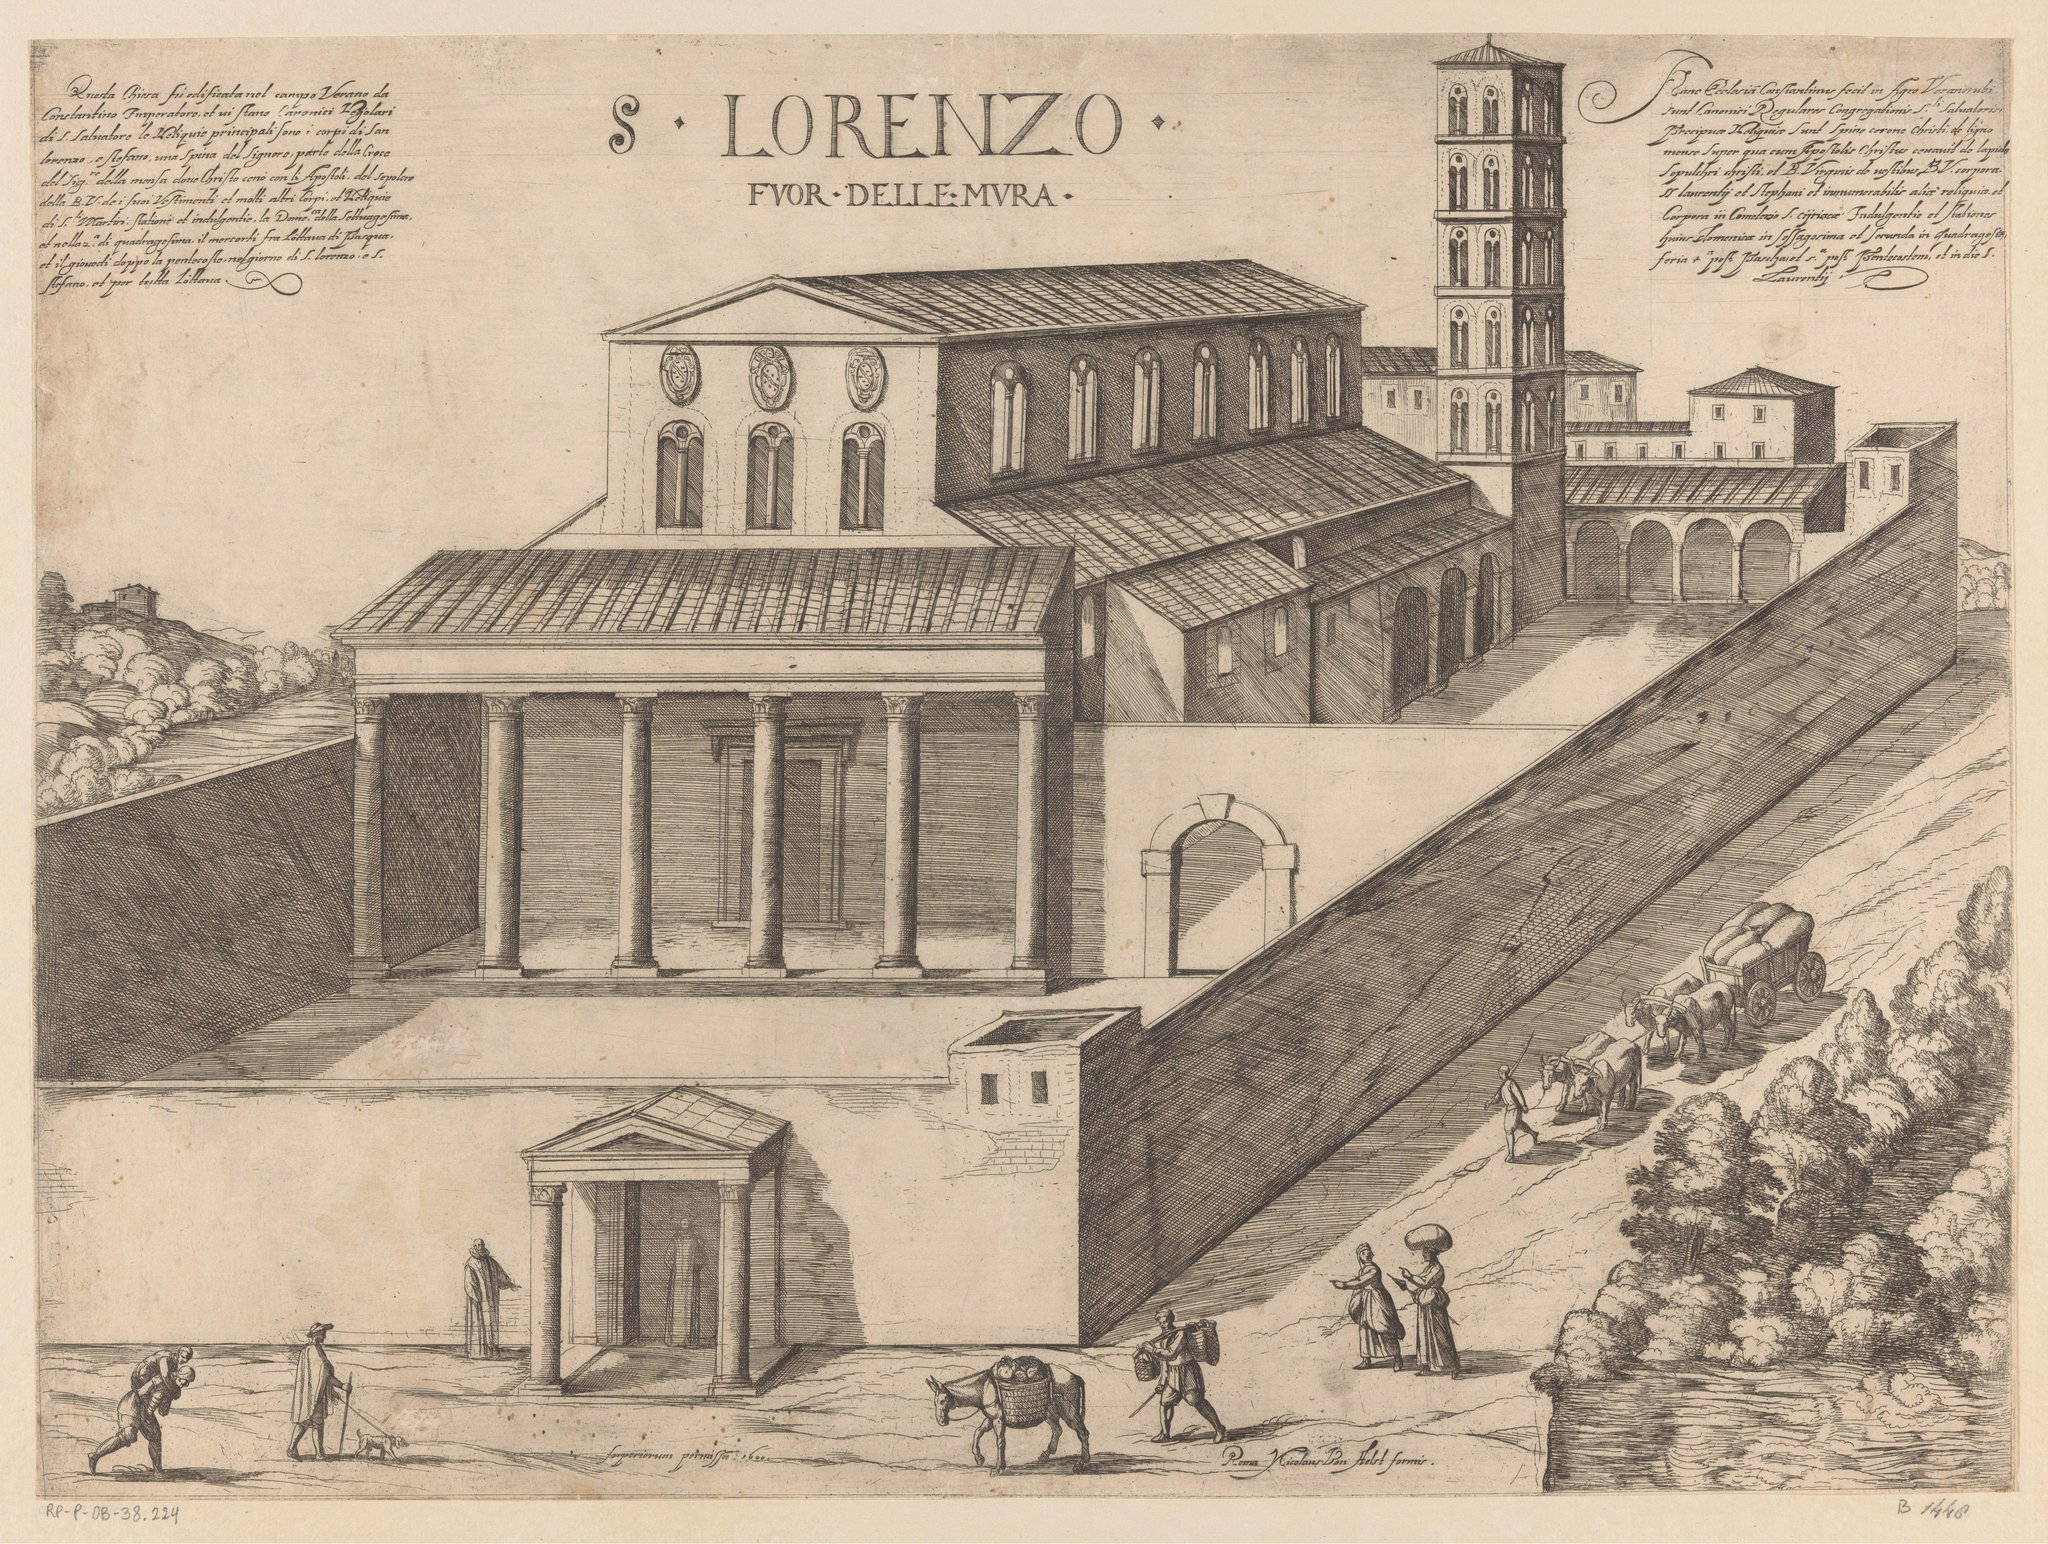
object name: print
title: S. Lorenzo fuor delle mura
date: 1600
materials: paper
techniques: etching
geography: vatican city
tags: church (exterior), roman catholic church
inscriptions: collector's mark: Lugt 240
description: Deze prent maakt deel uit van een reeks van negen prenten van de negen hoofdkerken van Rome.